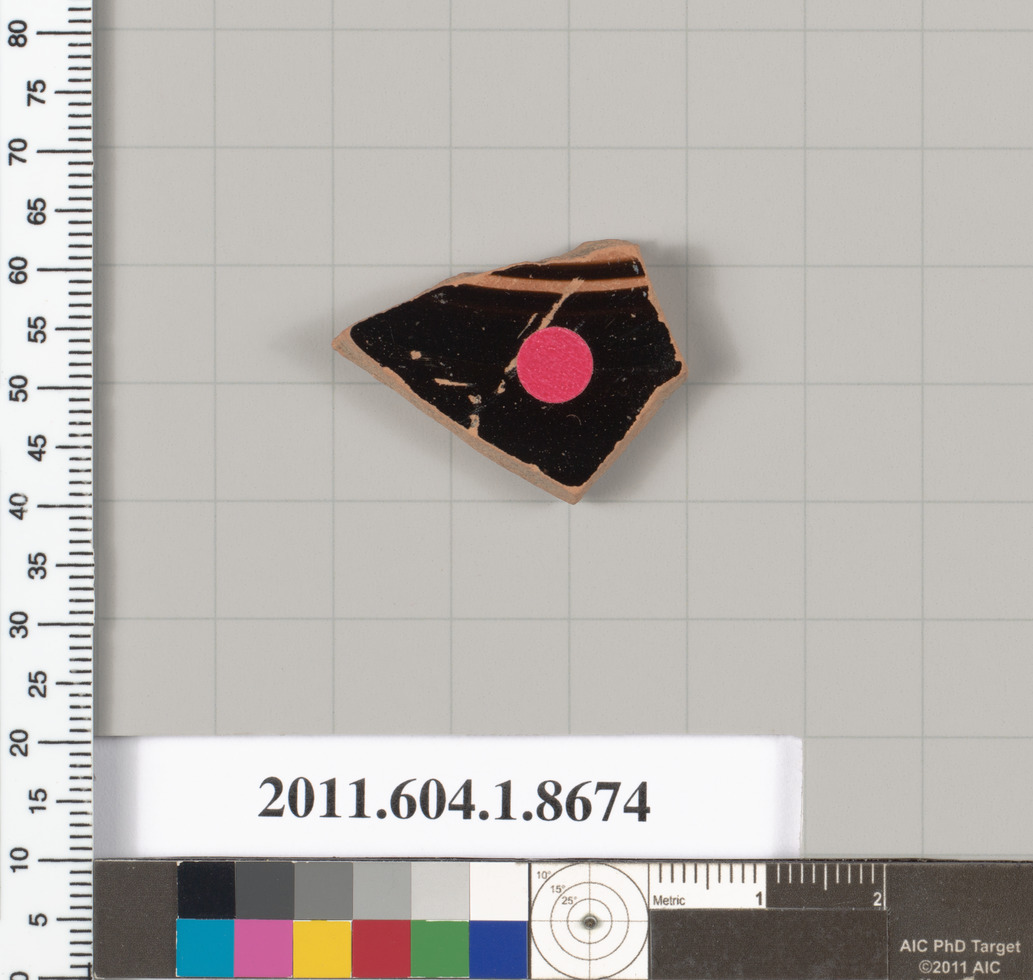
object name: kylix fragment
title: Terracotta fragment of a stemless kylix (drinking cup)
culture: greek, attic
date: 467-435 BCE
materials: terracotta